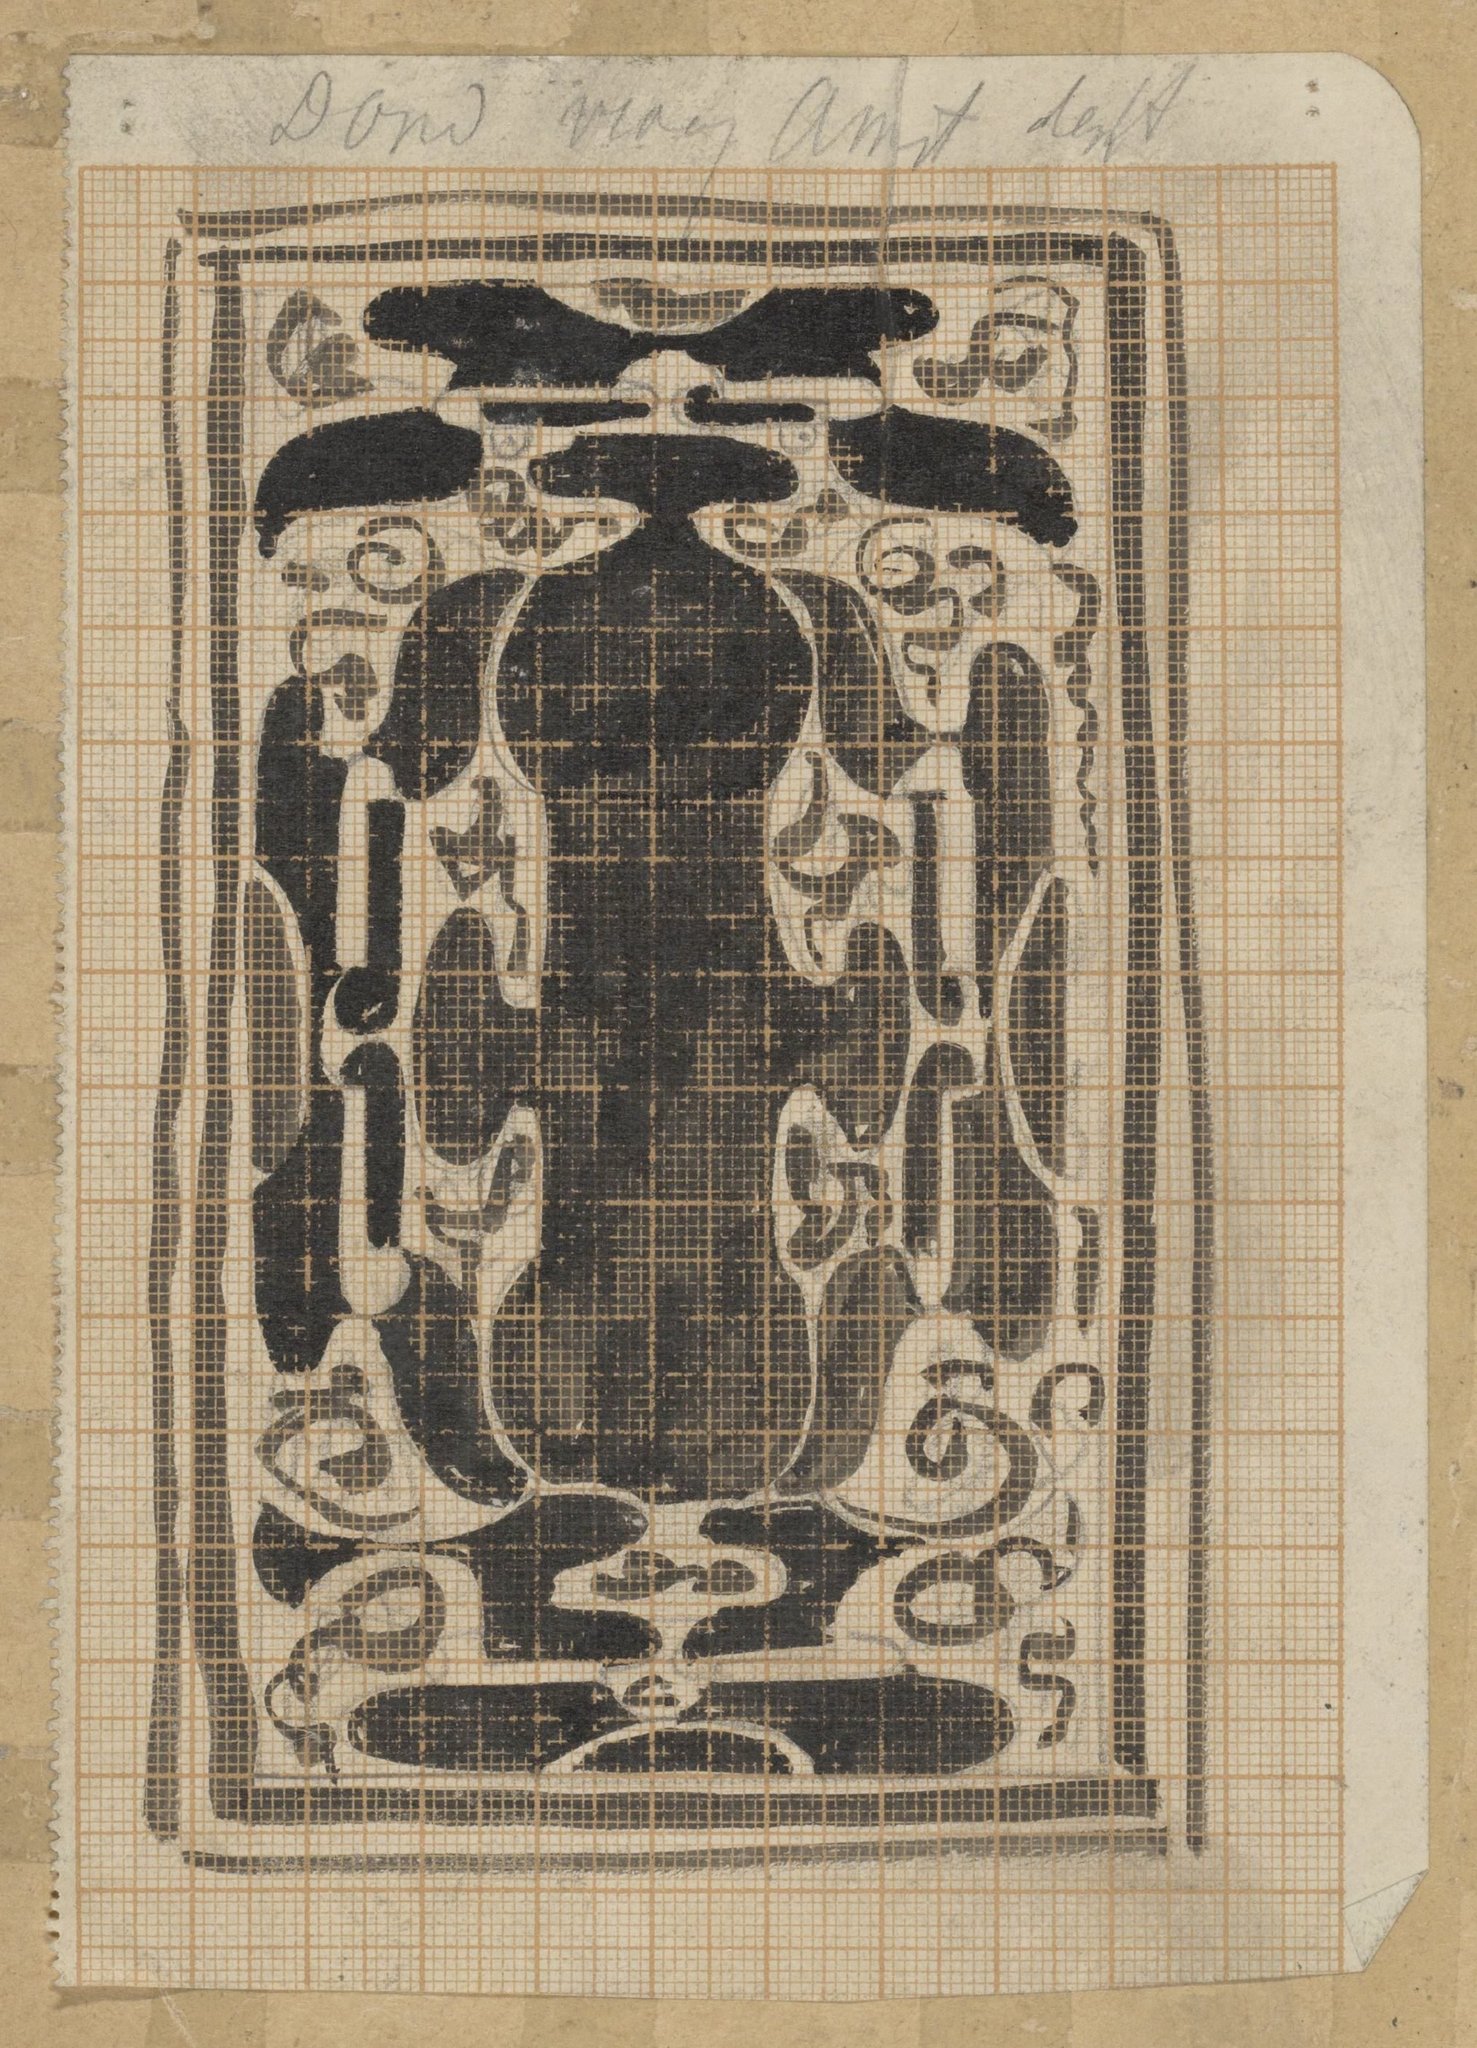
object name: drawing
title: Decoratief ontwerp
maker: carel adolph lion cachet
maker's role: draughtsman, print maker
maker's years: 1864-1945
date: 1874-1945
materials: pencil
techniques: brush